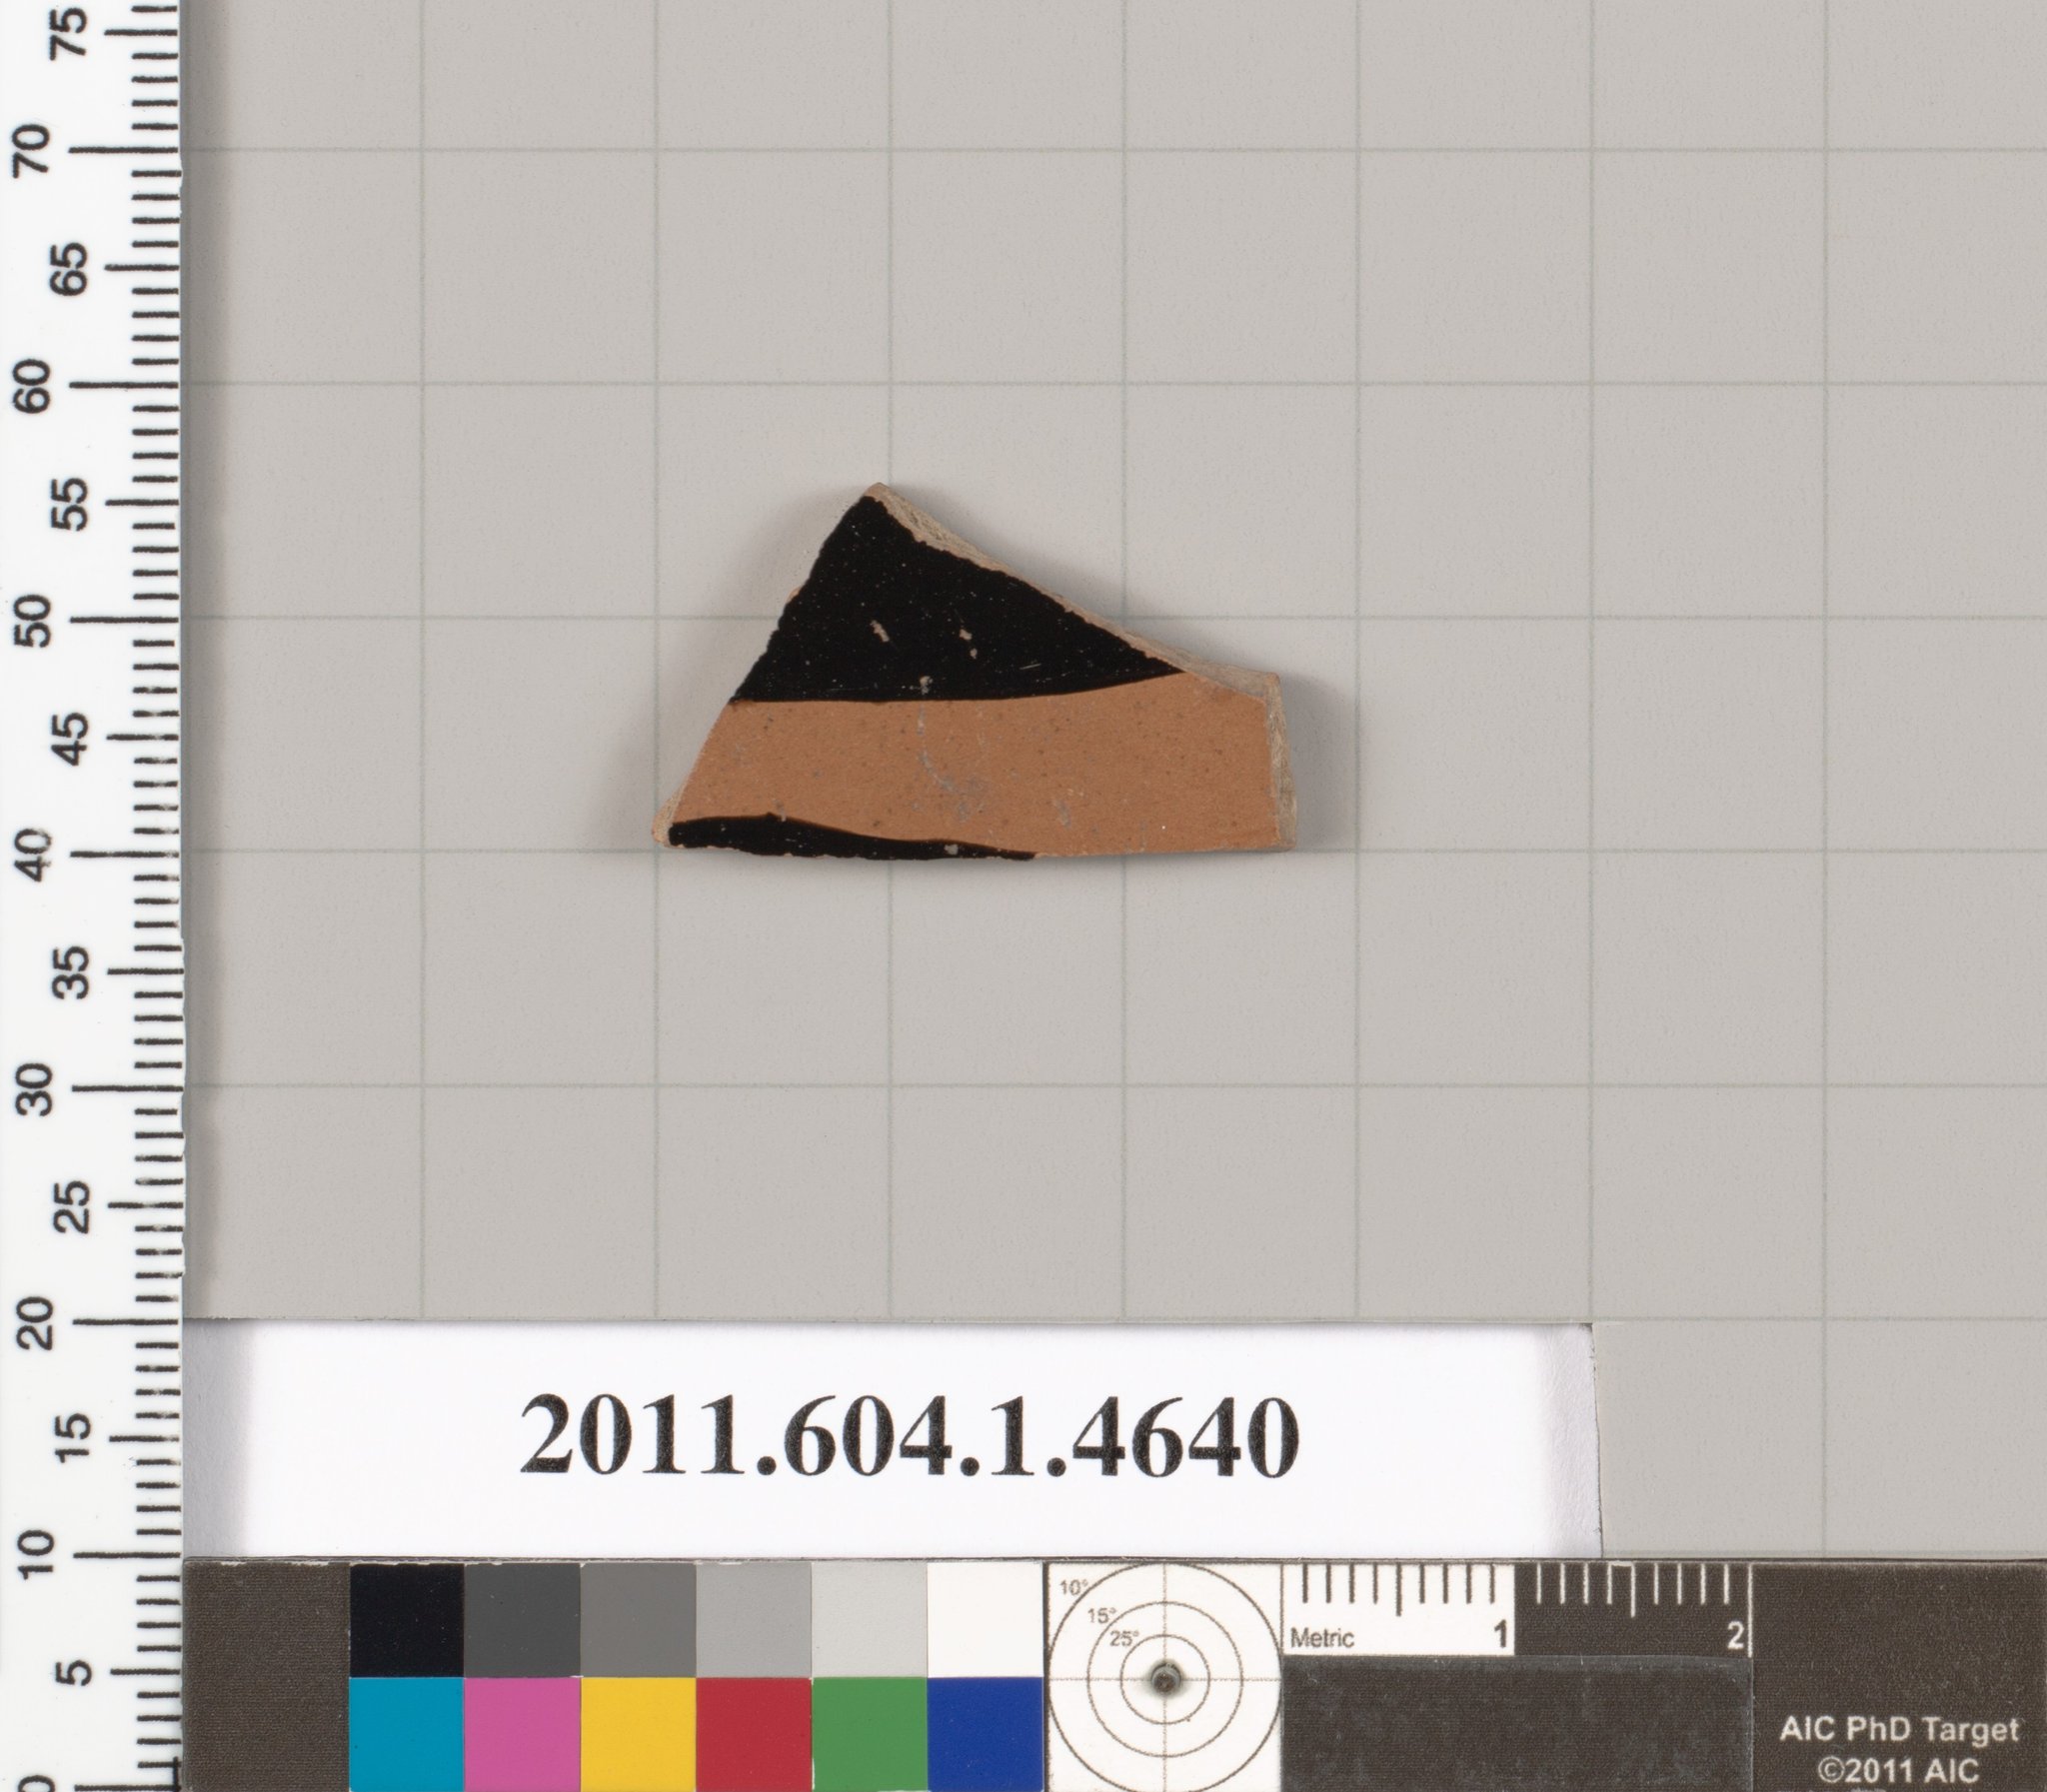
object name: kylix fragment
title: Terracotta fragment of a kylix (drinking cup)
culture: greek, attic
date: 475-451 BCE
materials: terracotta